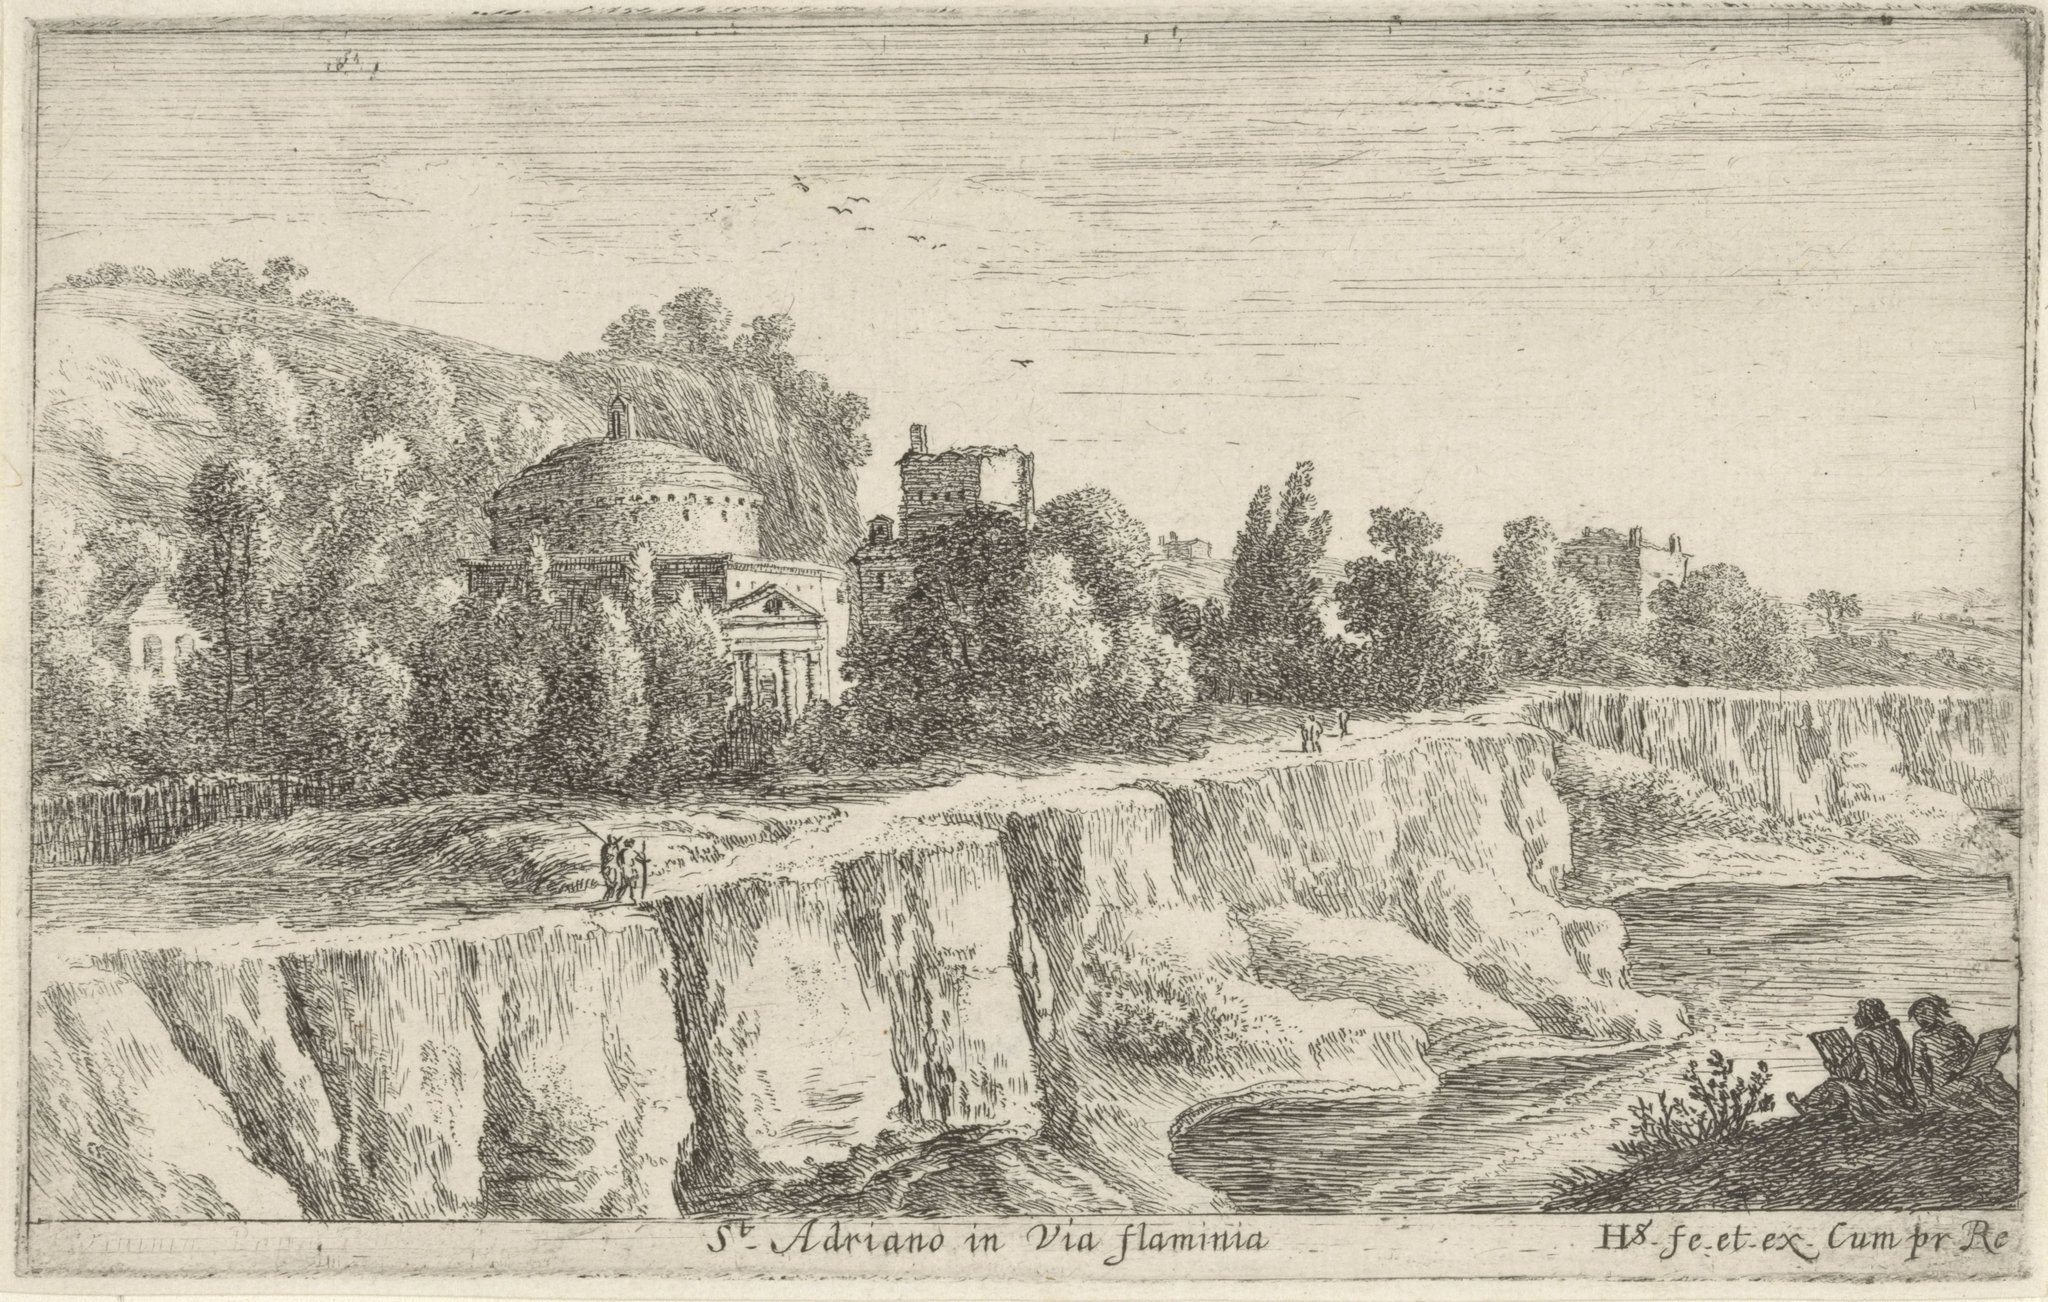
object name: print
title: S. Andrea in Via Flaminia bij Rome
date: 1652-1653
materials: paper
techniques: etching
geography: paris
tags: landscapes, river, roman catholic church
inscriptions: collector's mark: Lugt 240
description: Aan de oever van de Via Flaminia ligt de S. Andrea in Via Flaminia. Voor de kerk zijn wandelaars te zien en aan de overkant zitten nog twee figuren.